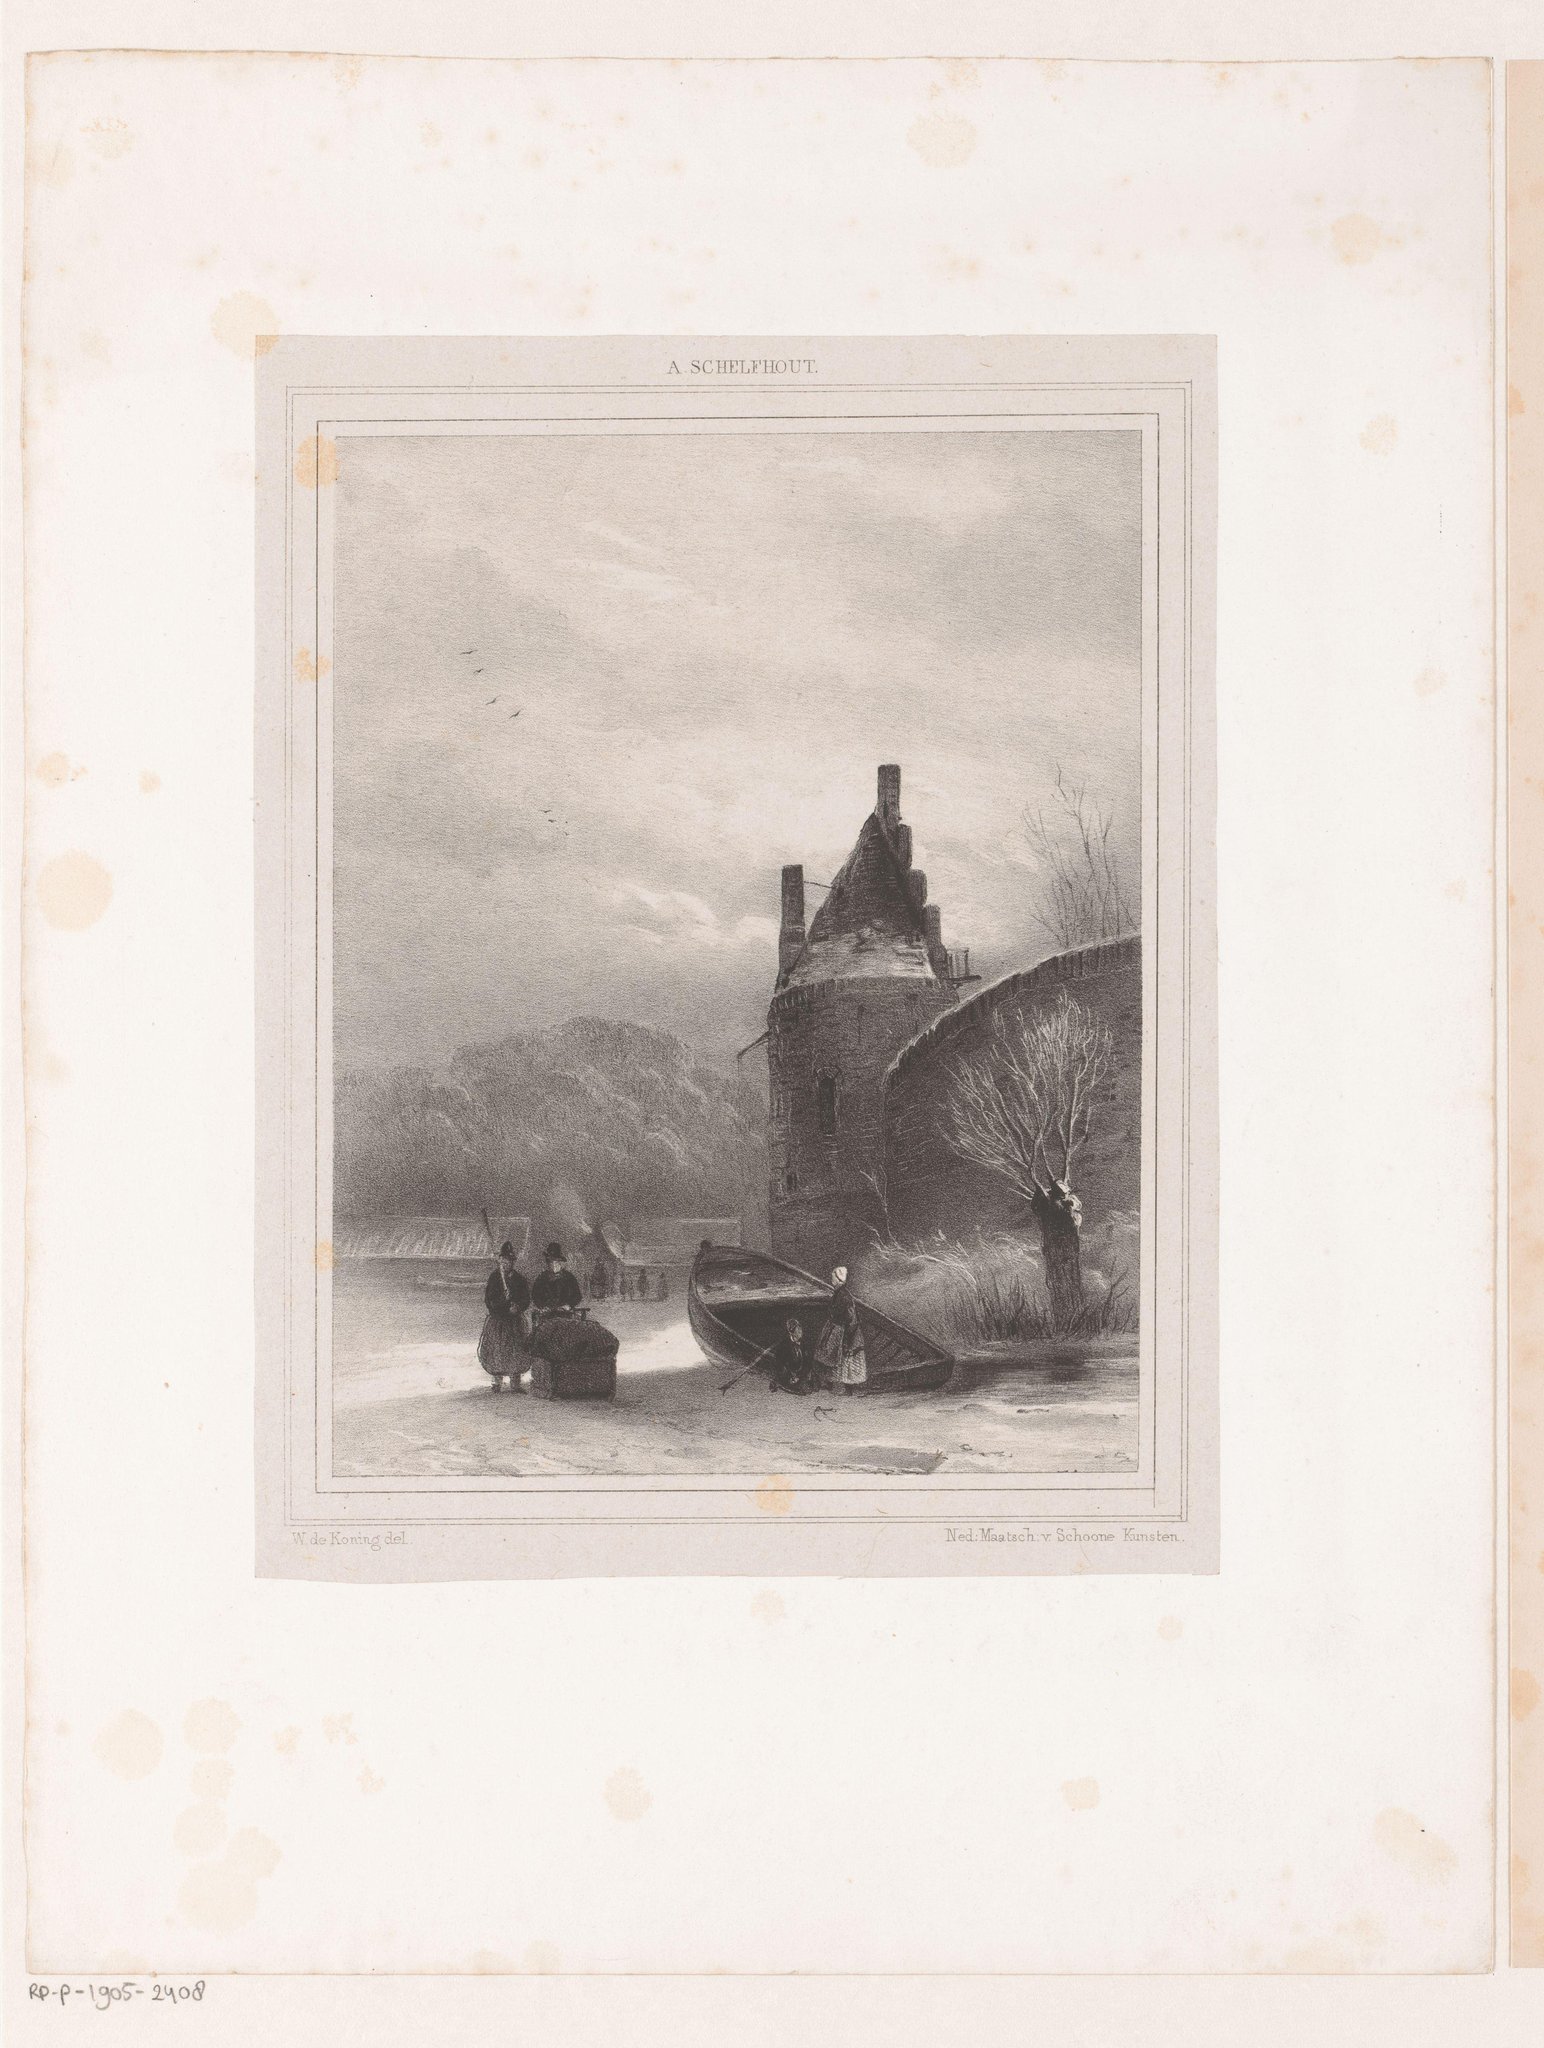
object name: print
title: Wintergezicht met stadsmuur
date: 1840-1843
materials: paper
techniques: lithograph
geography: the hague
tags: towers ~ fortified city, sleigh, sledge (non-sport), winter landscape; landscape symbolizing winter (the four seasons of the year)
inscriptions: collector's mark: Lugt 2228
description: Op het ijs lopen twee figuren met een slede. Rechts, bij een vastgevroren boot, staan nog twee figuren. Rechts daarvan de stadsmuur met een toren.